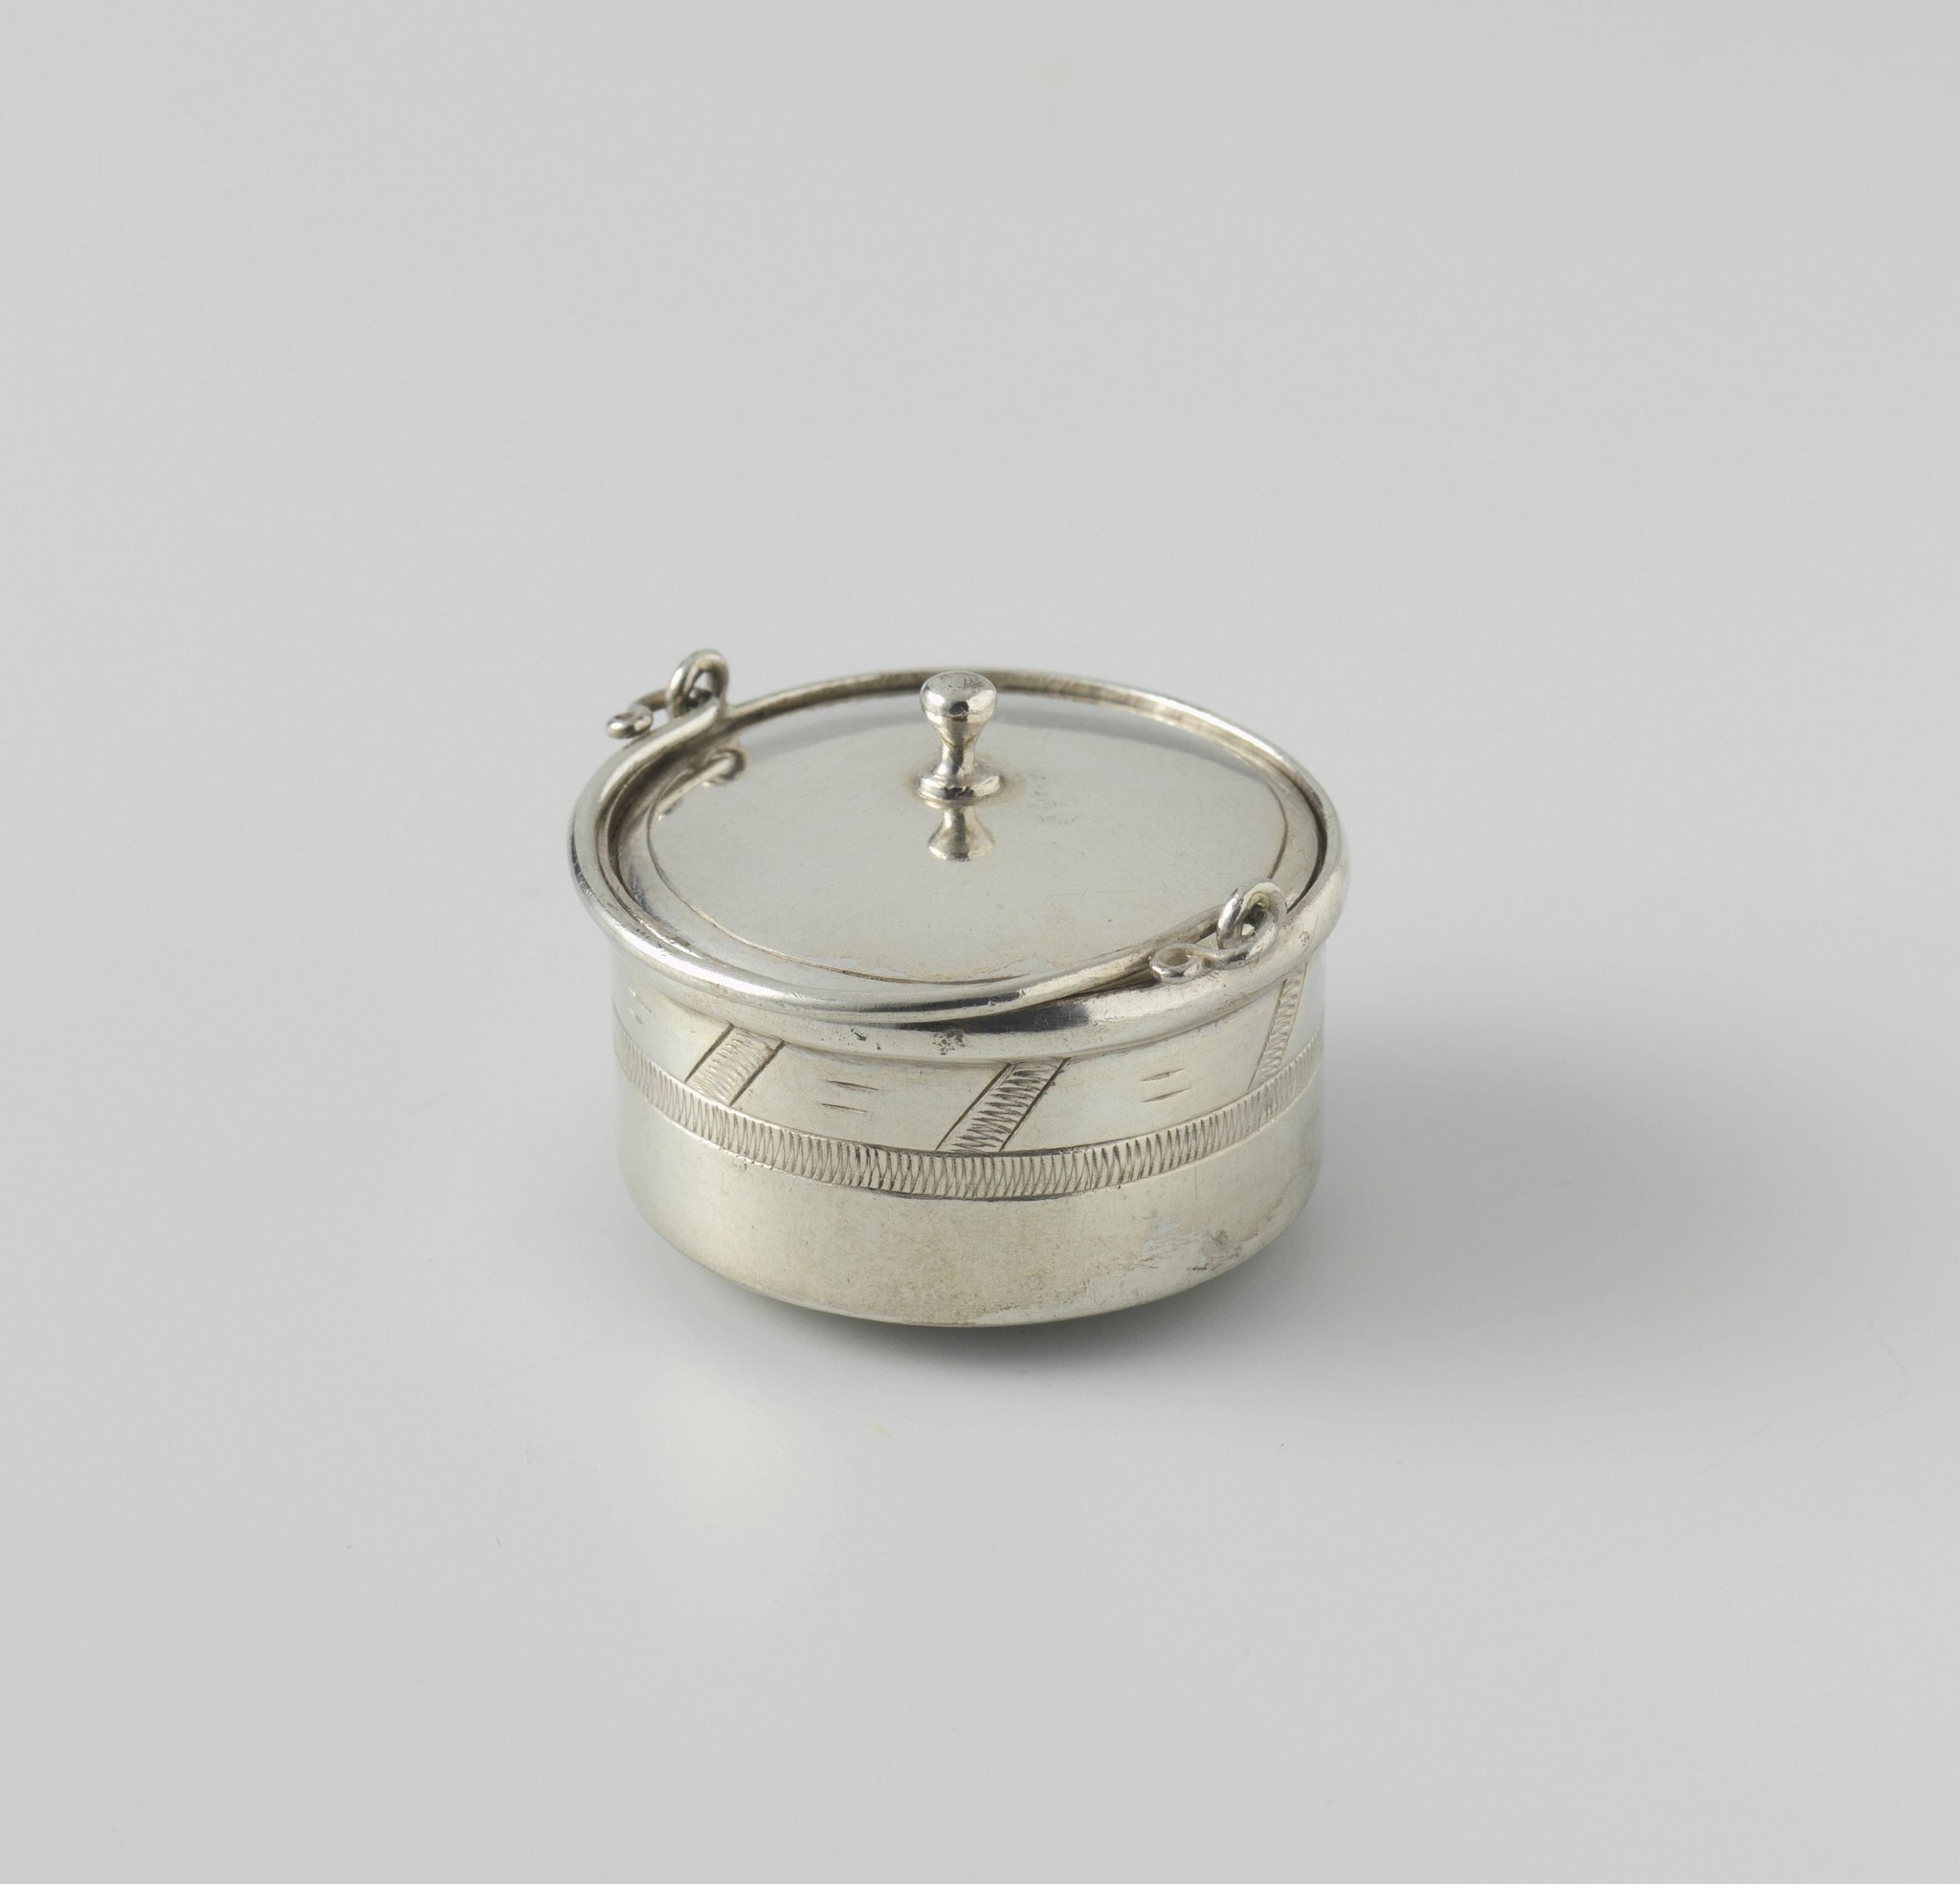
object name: miniature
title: Ketel met deksel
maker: frederik van strant (i)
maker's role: silversmith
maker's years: 1678-1727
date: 1725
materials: silver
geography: amsterdam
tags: kitchen-utensils: pot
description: Ketel met deksel en hengsel. In de pan zijn zig-zag lijnen gegraveerd. Op het deksel zit een knop. De ketel is gemerkt: mt.= Frederik van Strant I.